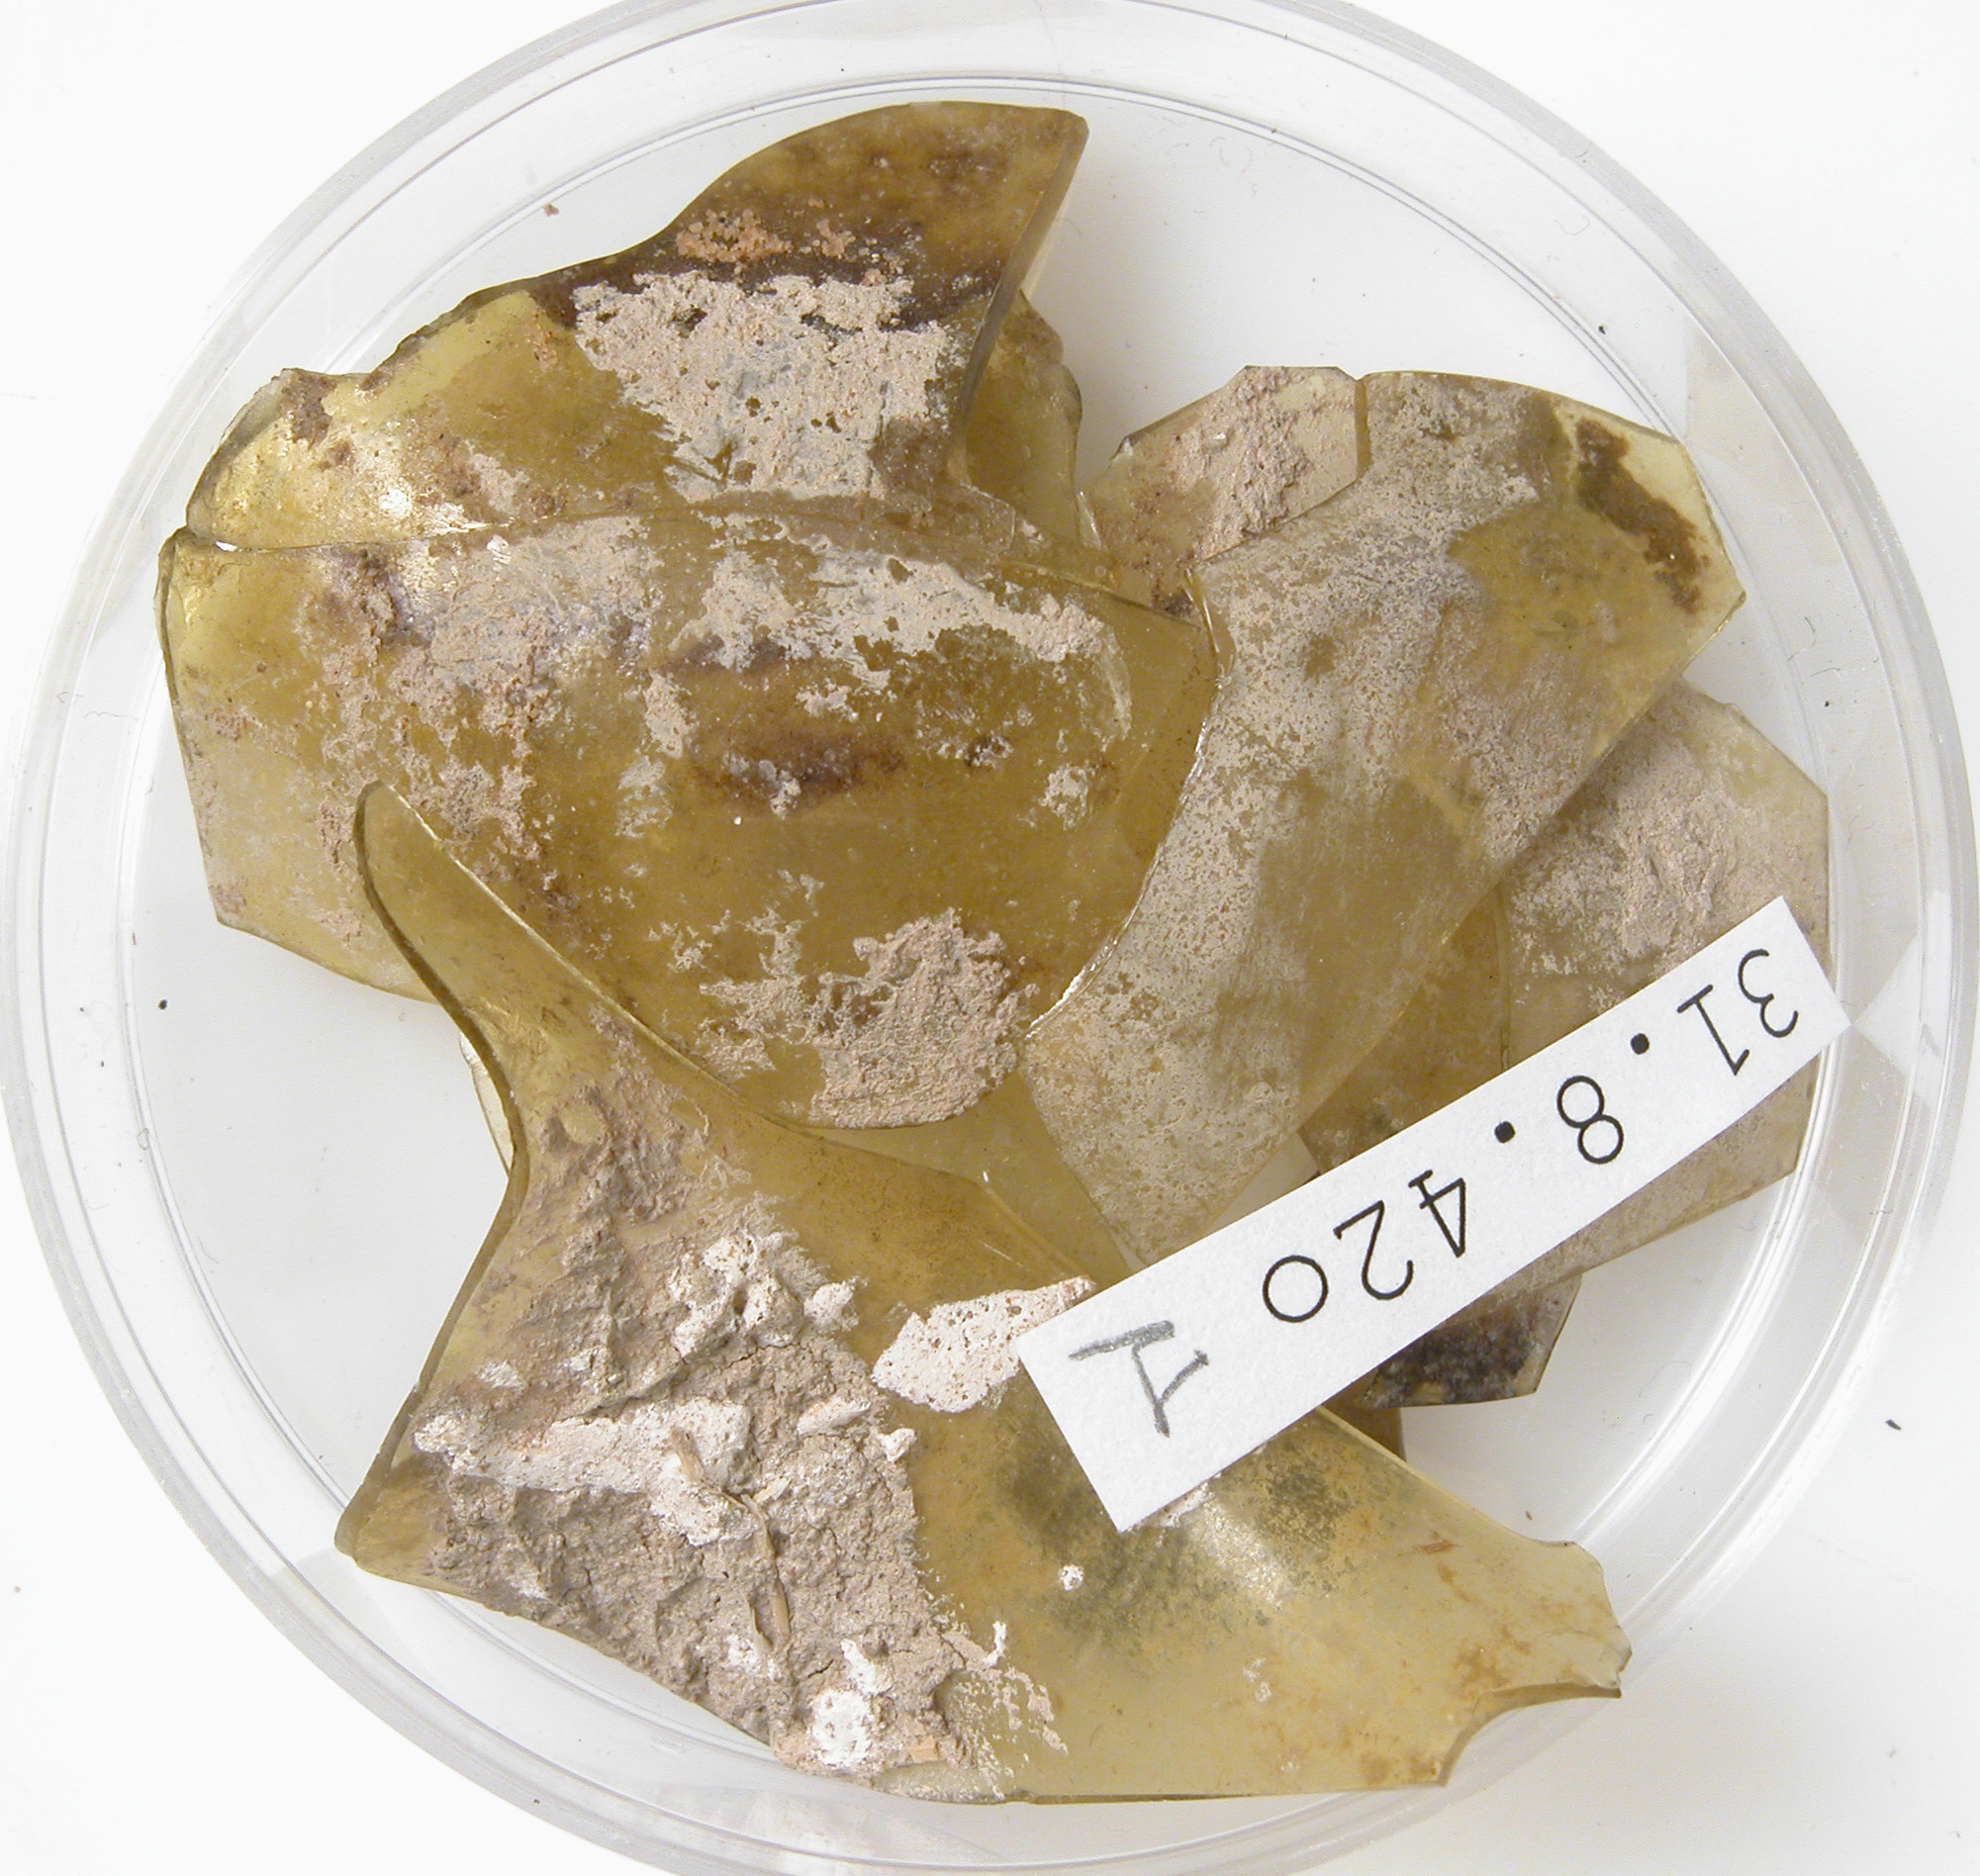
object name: fragment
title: Glass Fragments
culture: coptic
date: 301-400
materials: glass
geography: egypt